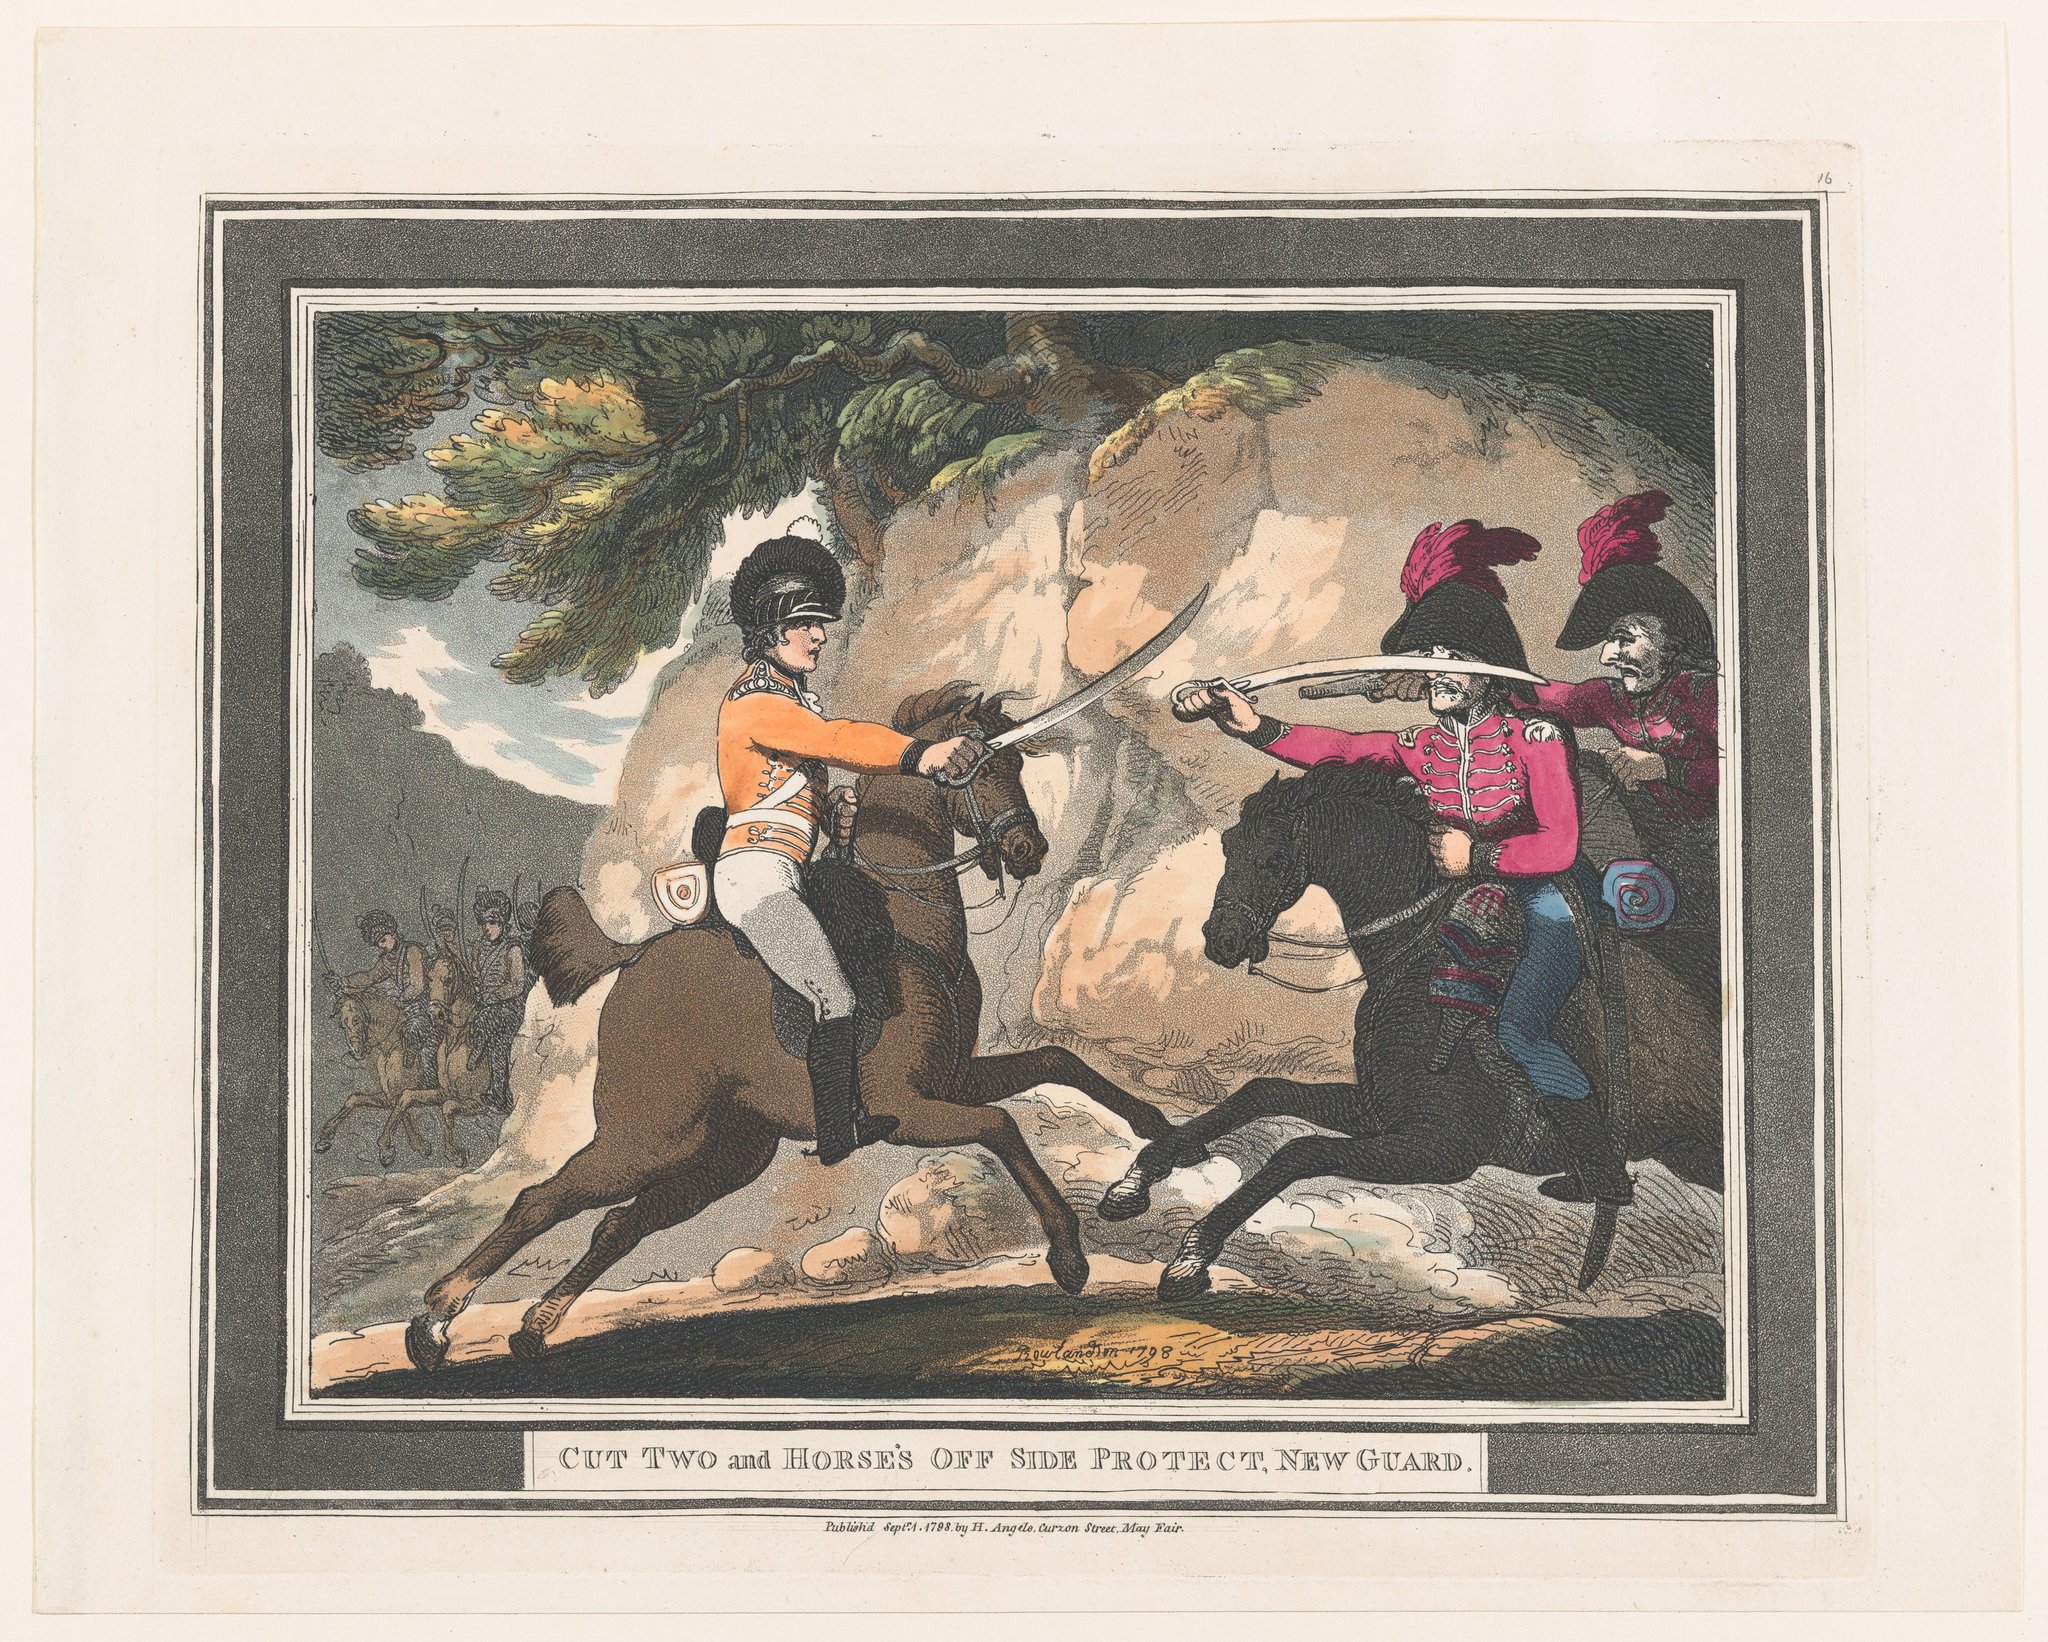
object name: print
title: Cut Two and Horse's Off Side Protect, New Guard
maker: thomas rowlandson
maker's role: artist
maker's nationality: british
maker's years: 1757-1827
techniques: aquatint, etching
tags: wars,swords,men,horses